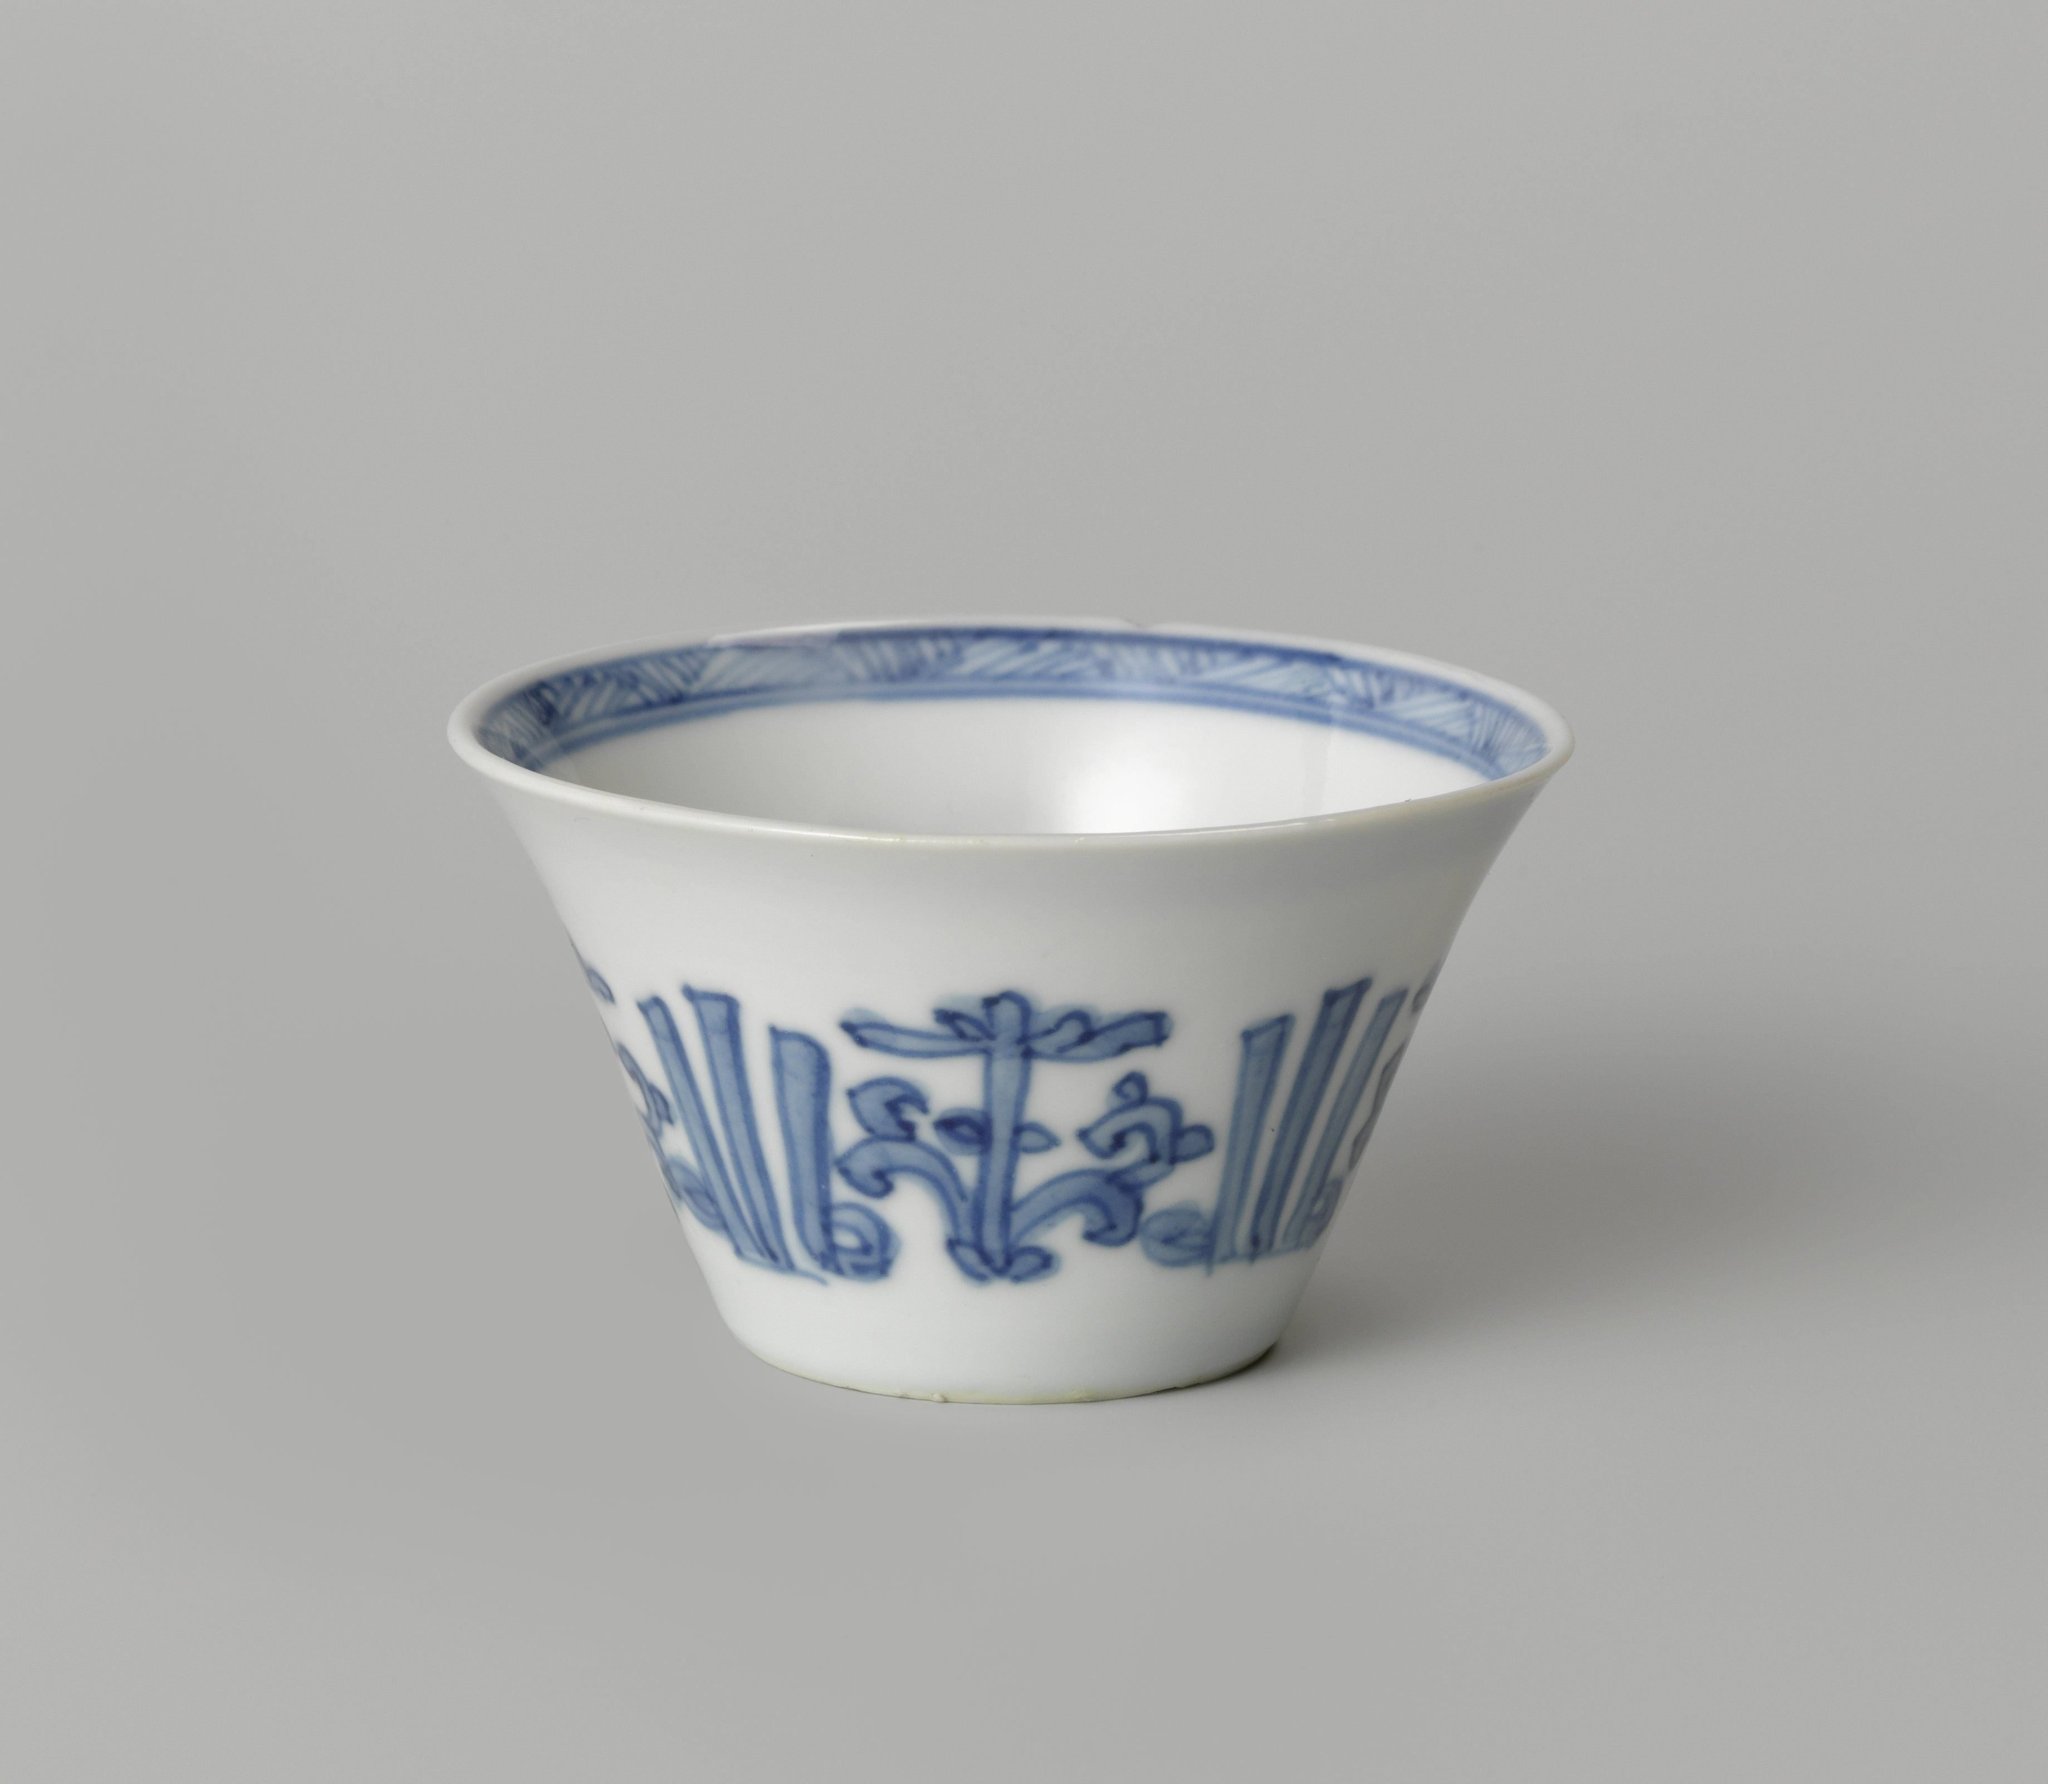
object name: cup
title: Cup with stylised flowers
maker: Anonymous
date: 1700-1724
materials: cobalt, glaze, paint, porcelain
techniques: firing, turning, vitrification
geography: china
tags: flowers ~ ornament - aa - stylized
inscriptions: mark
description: Kop van porselein met spreidende wand, beschilderd in onderglazuur blauw. Op de buitenwand een band met gestileerde bloemranken afgewisseld met drie lijnen. Op de bodem een gestileerde bloemrozet. De binnenrand met een band met een zigzag-patroon. Gemerkt op de onderzijde met het vier-karaktermerk van keizer Yongzheng (?) in een dubbele cirkel. Blauw-wit.